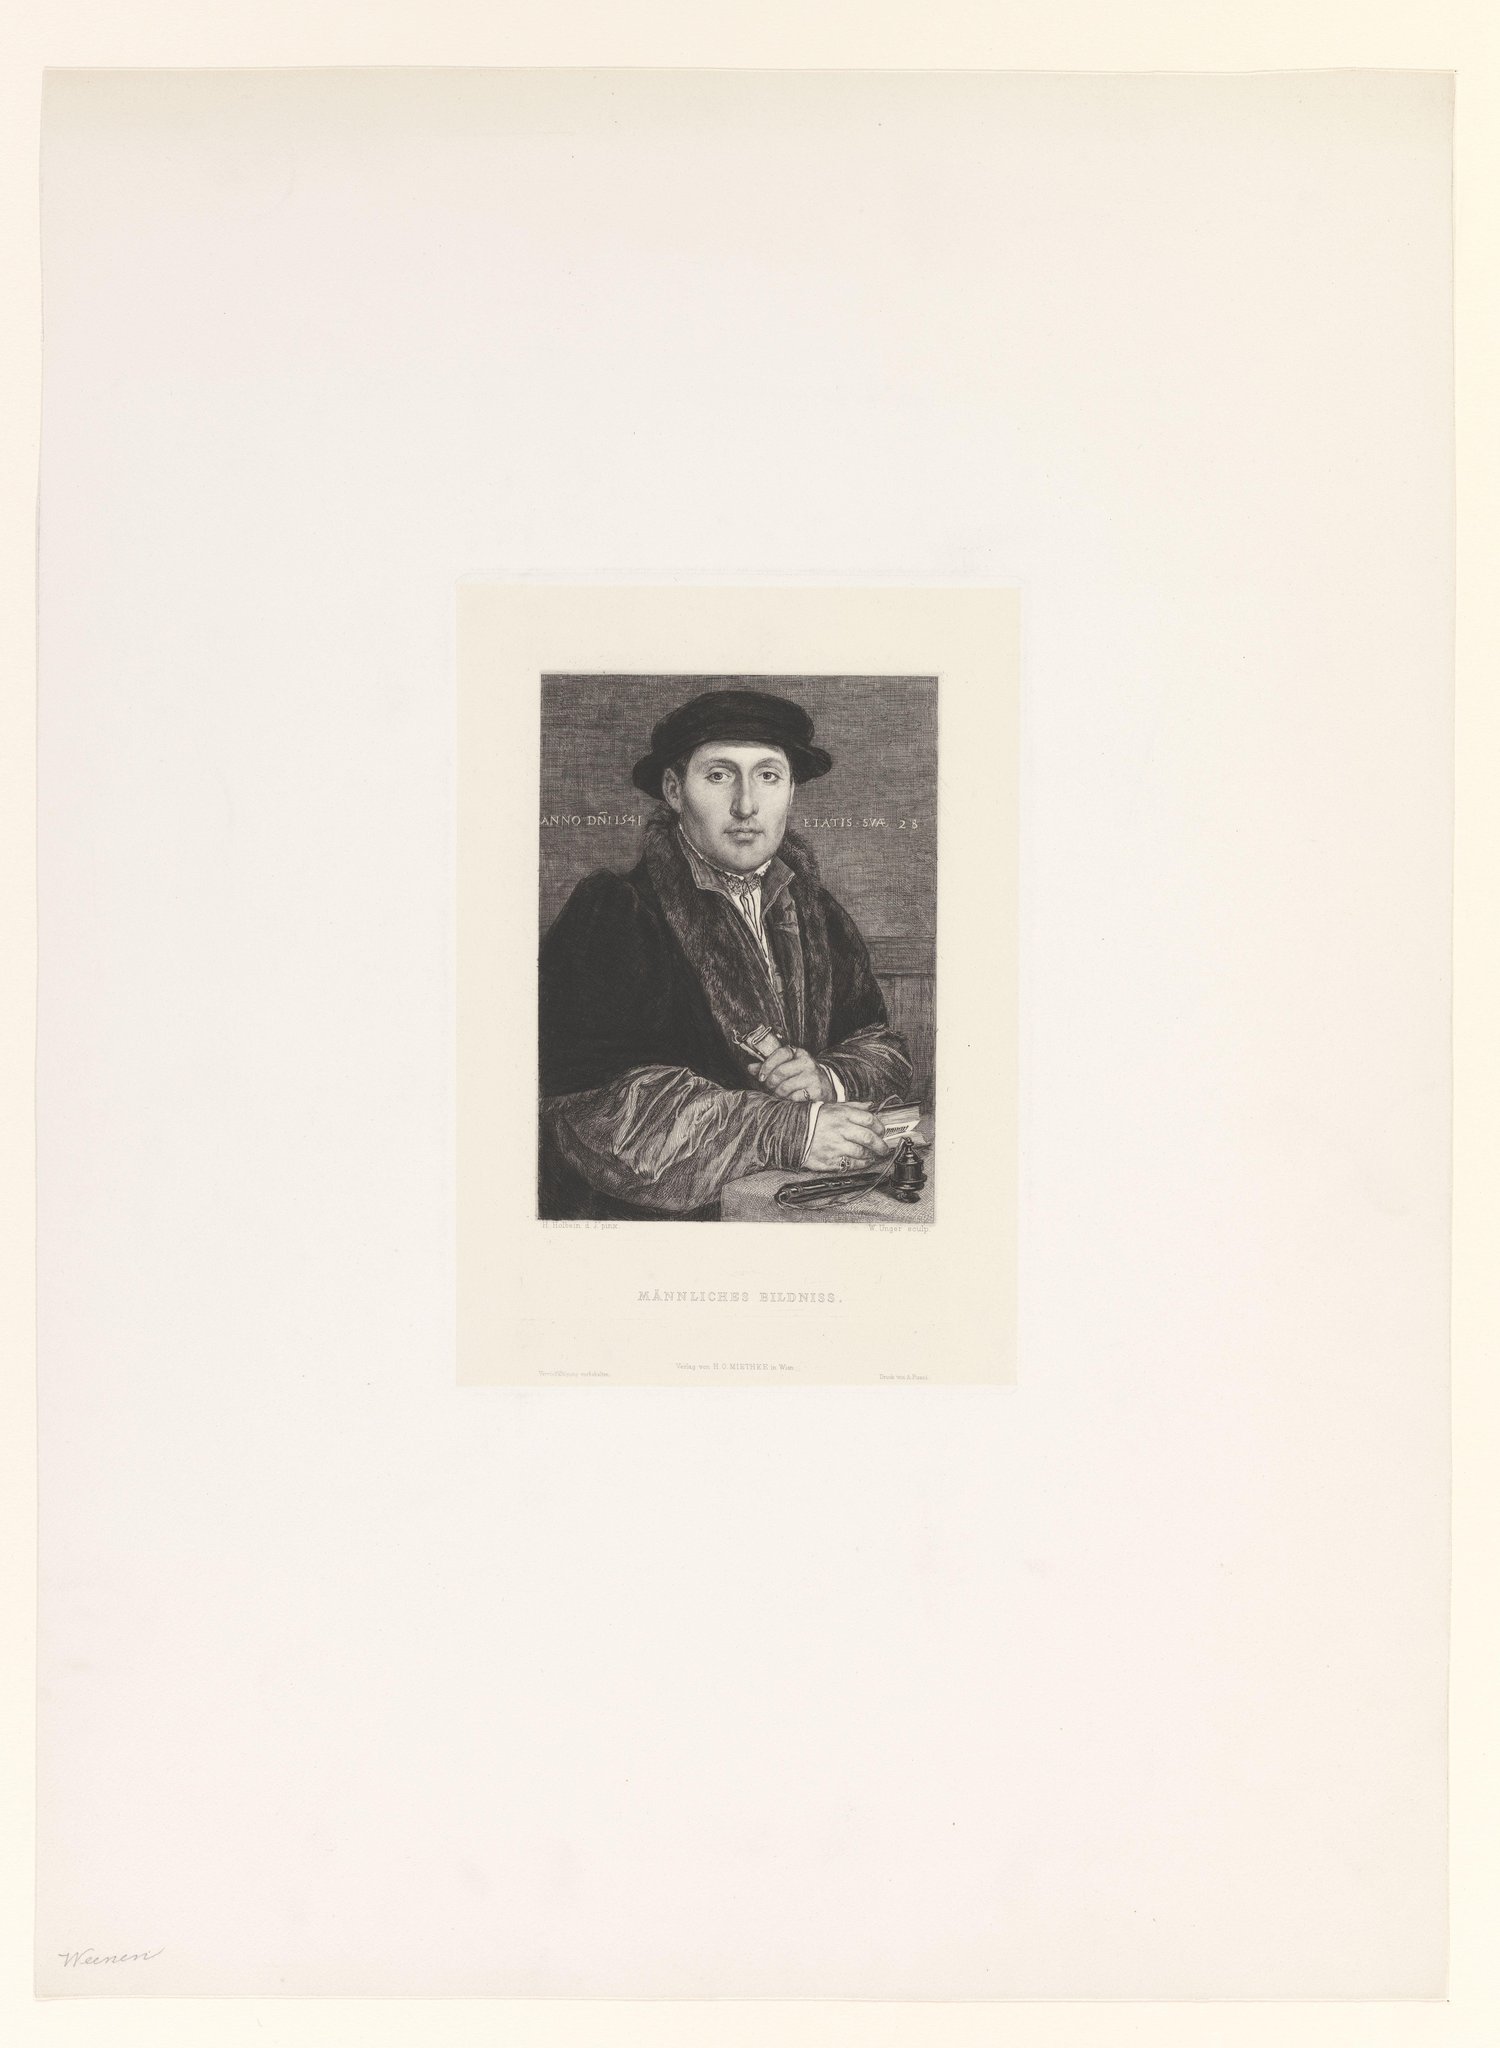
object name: print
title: Männliches Bildniss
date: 1861-1889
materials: paper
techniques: etching, intaglio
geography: vienna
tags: gloves, mittens, etc., book, anonymous historical person portrayed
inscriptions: collector's mark: Lugt 2228